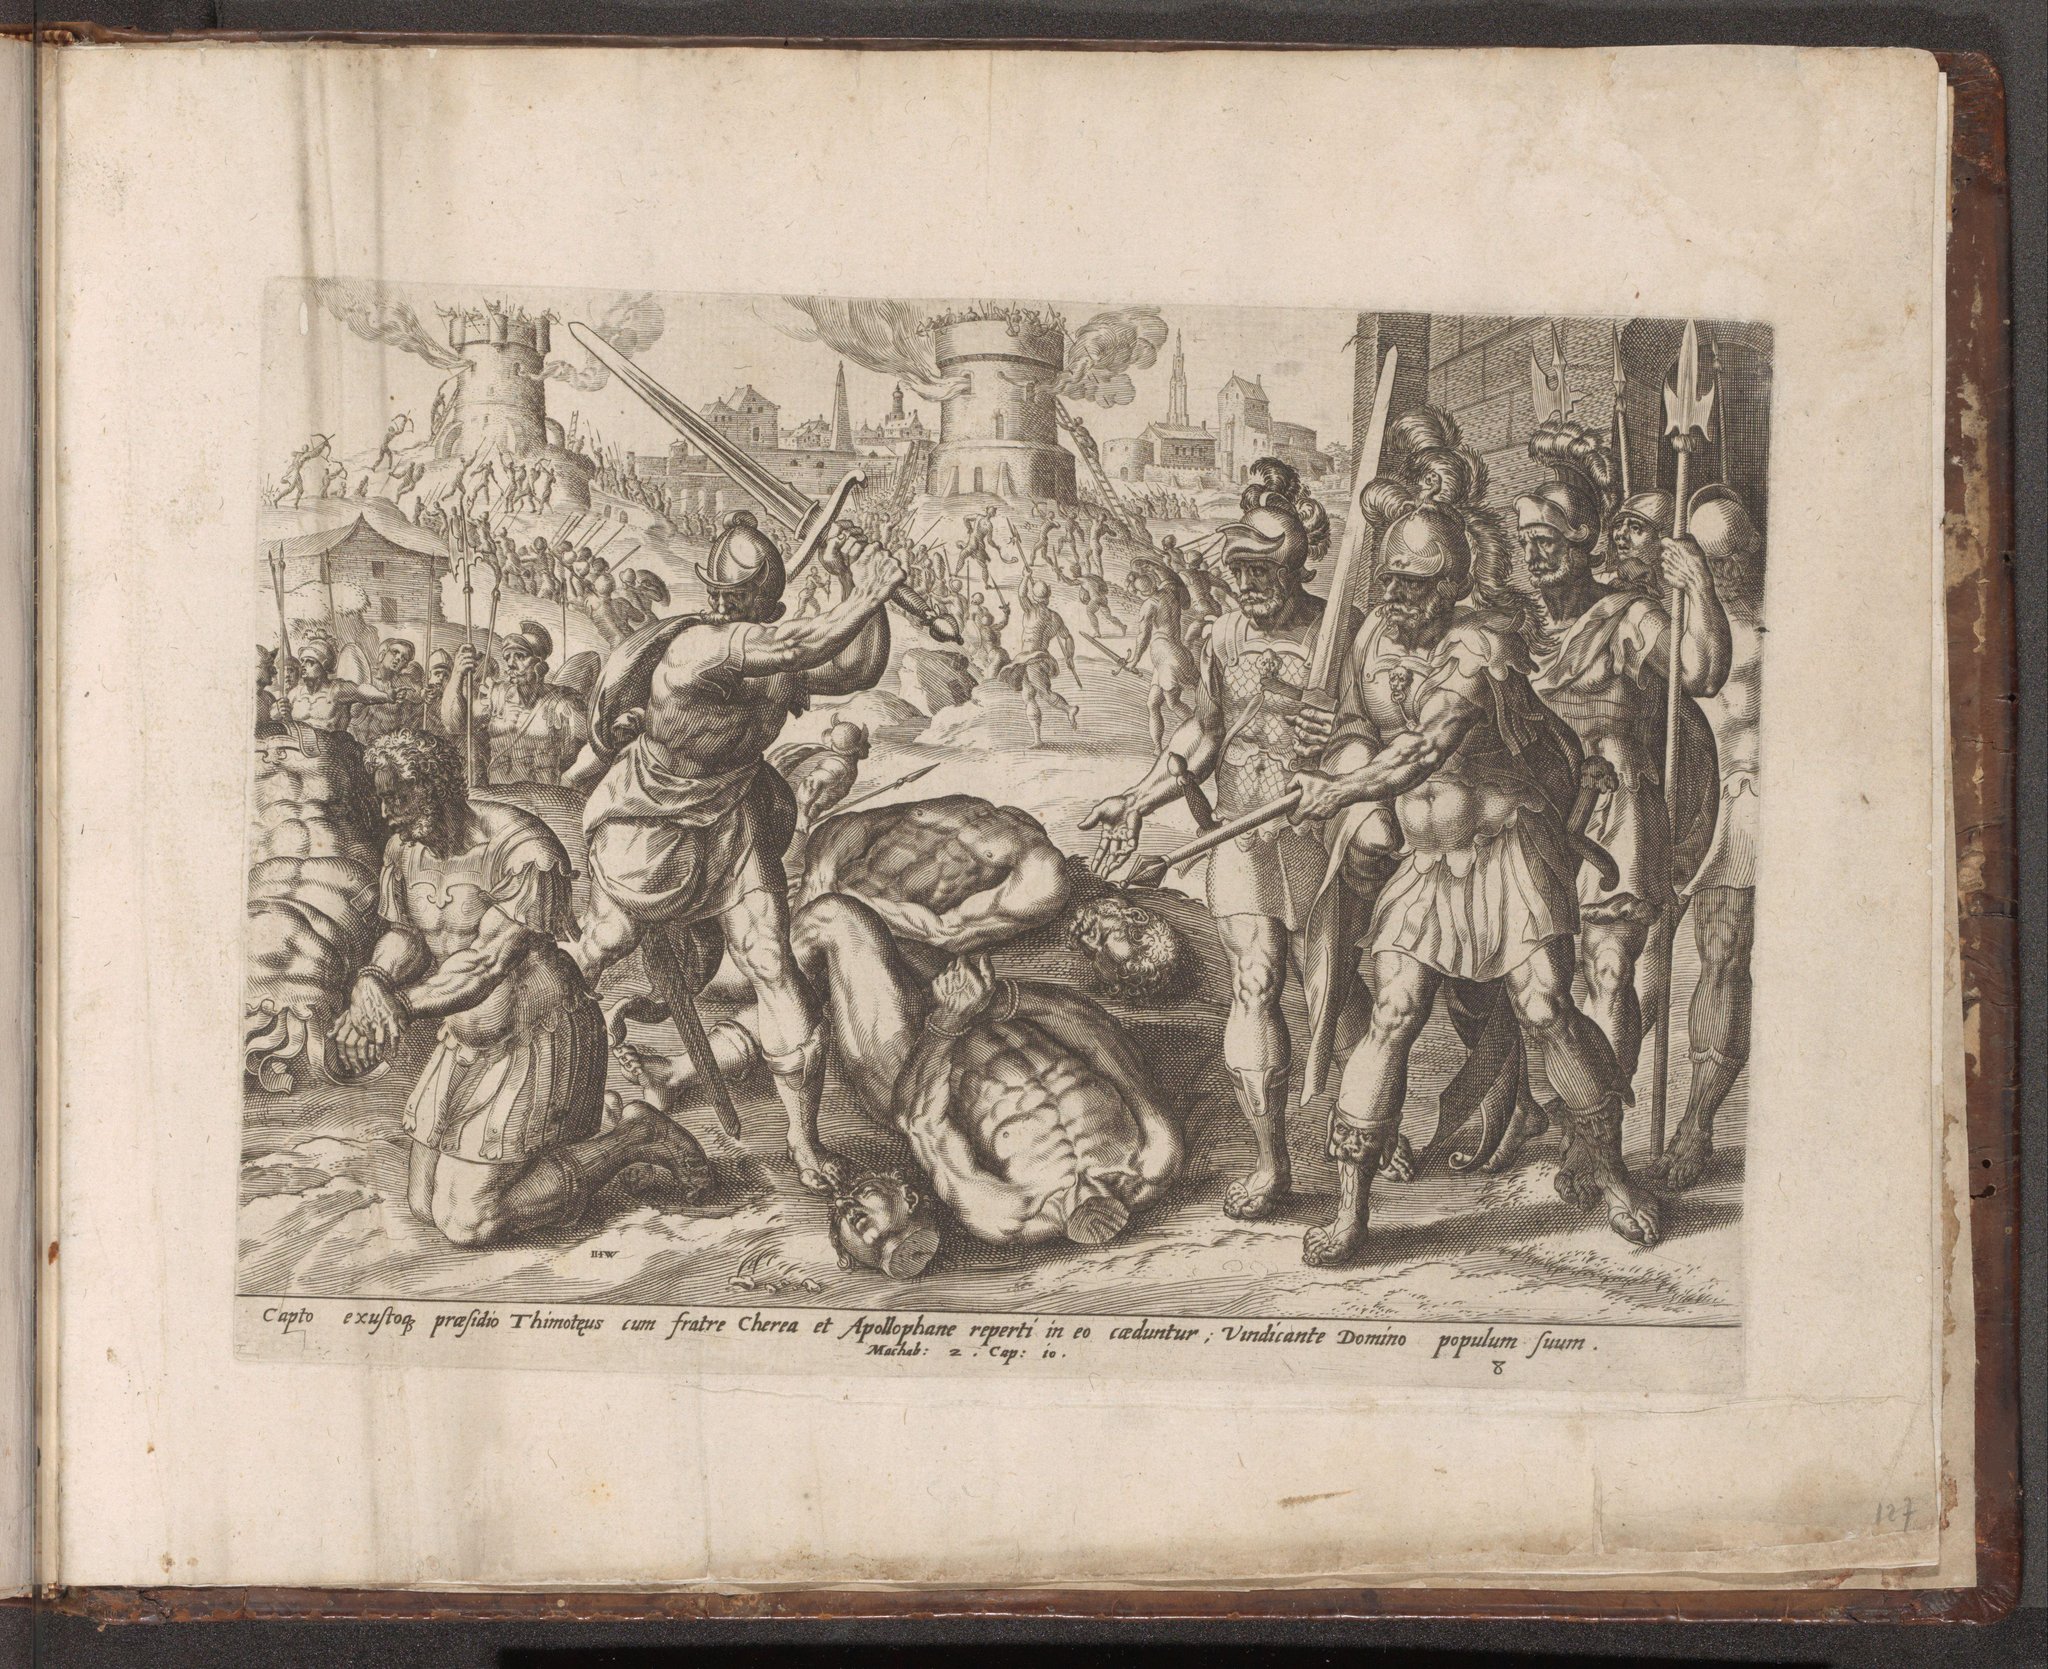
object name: album leaf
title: Geschiedenis van de Makkabeeën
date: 1579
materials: paper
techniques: engraving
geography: antwerp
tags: other scenes ~ second book of the maccabees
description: Het leger van Judas Makkabeeër bestormt de muren van de burcht. Ze steken de torens in brand. Timoteüs en zijn broers Chereas en Apollofanes worden gedood. Onder de voorstelling een verwijzing in het Latijn naar de Bijbeltekst in 2 Makk. 10:32. Prent maakt deel uit van een album.